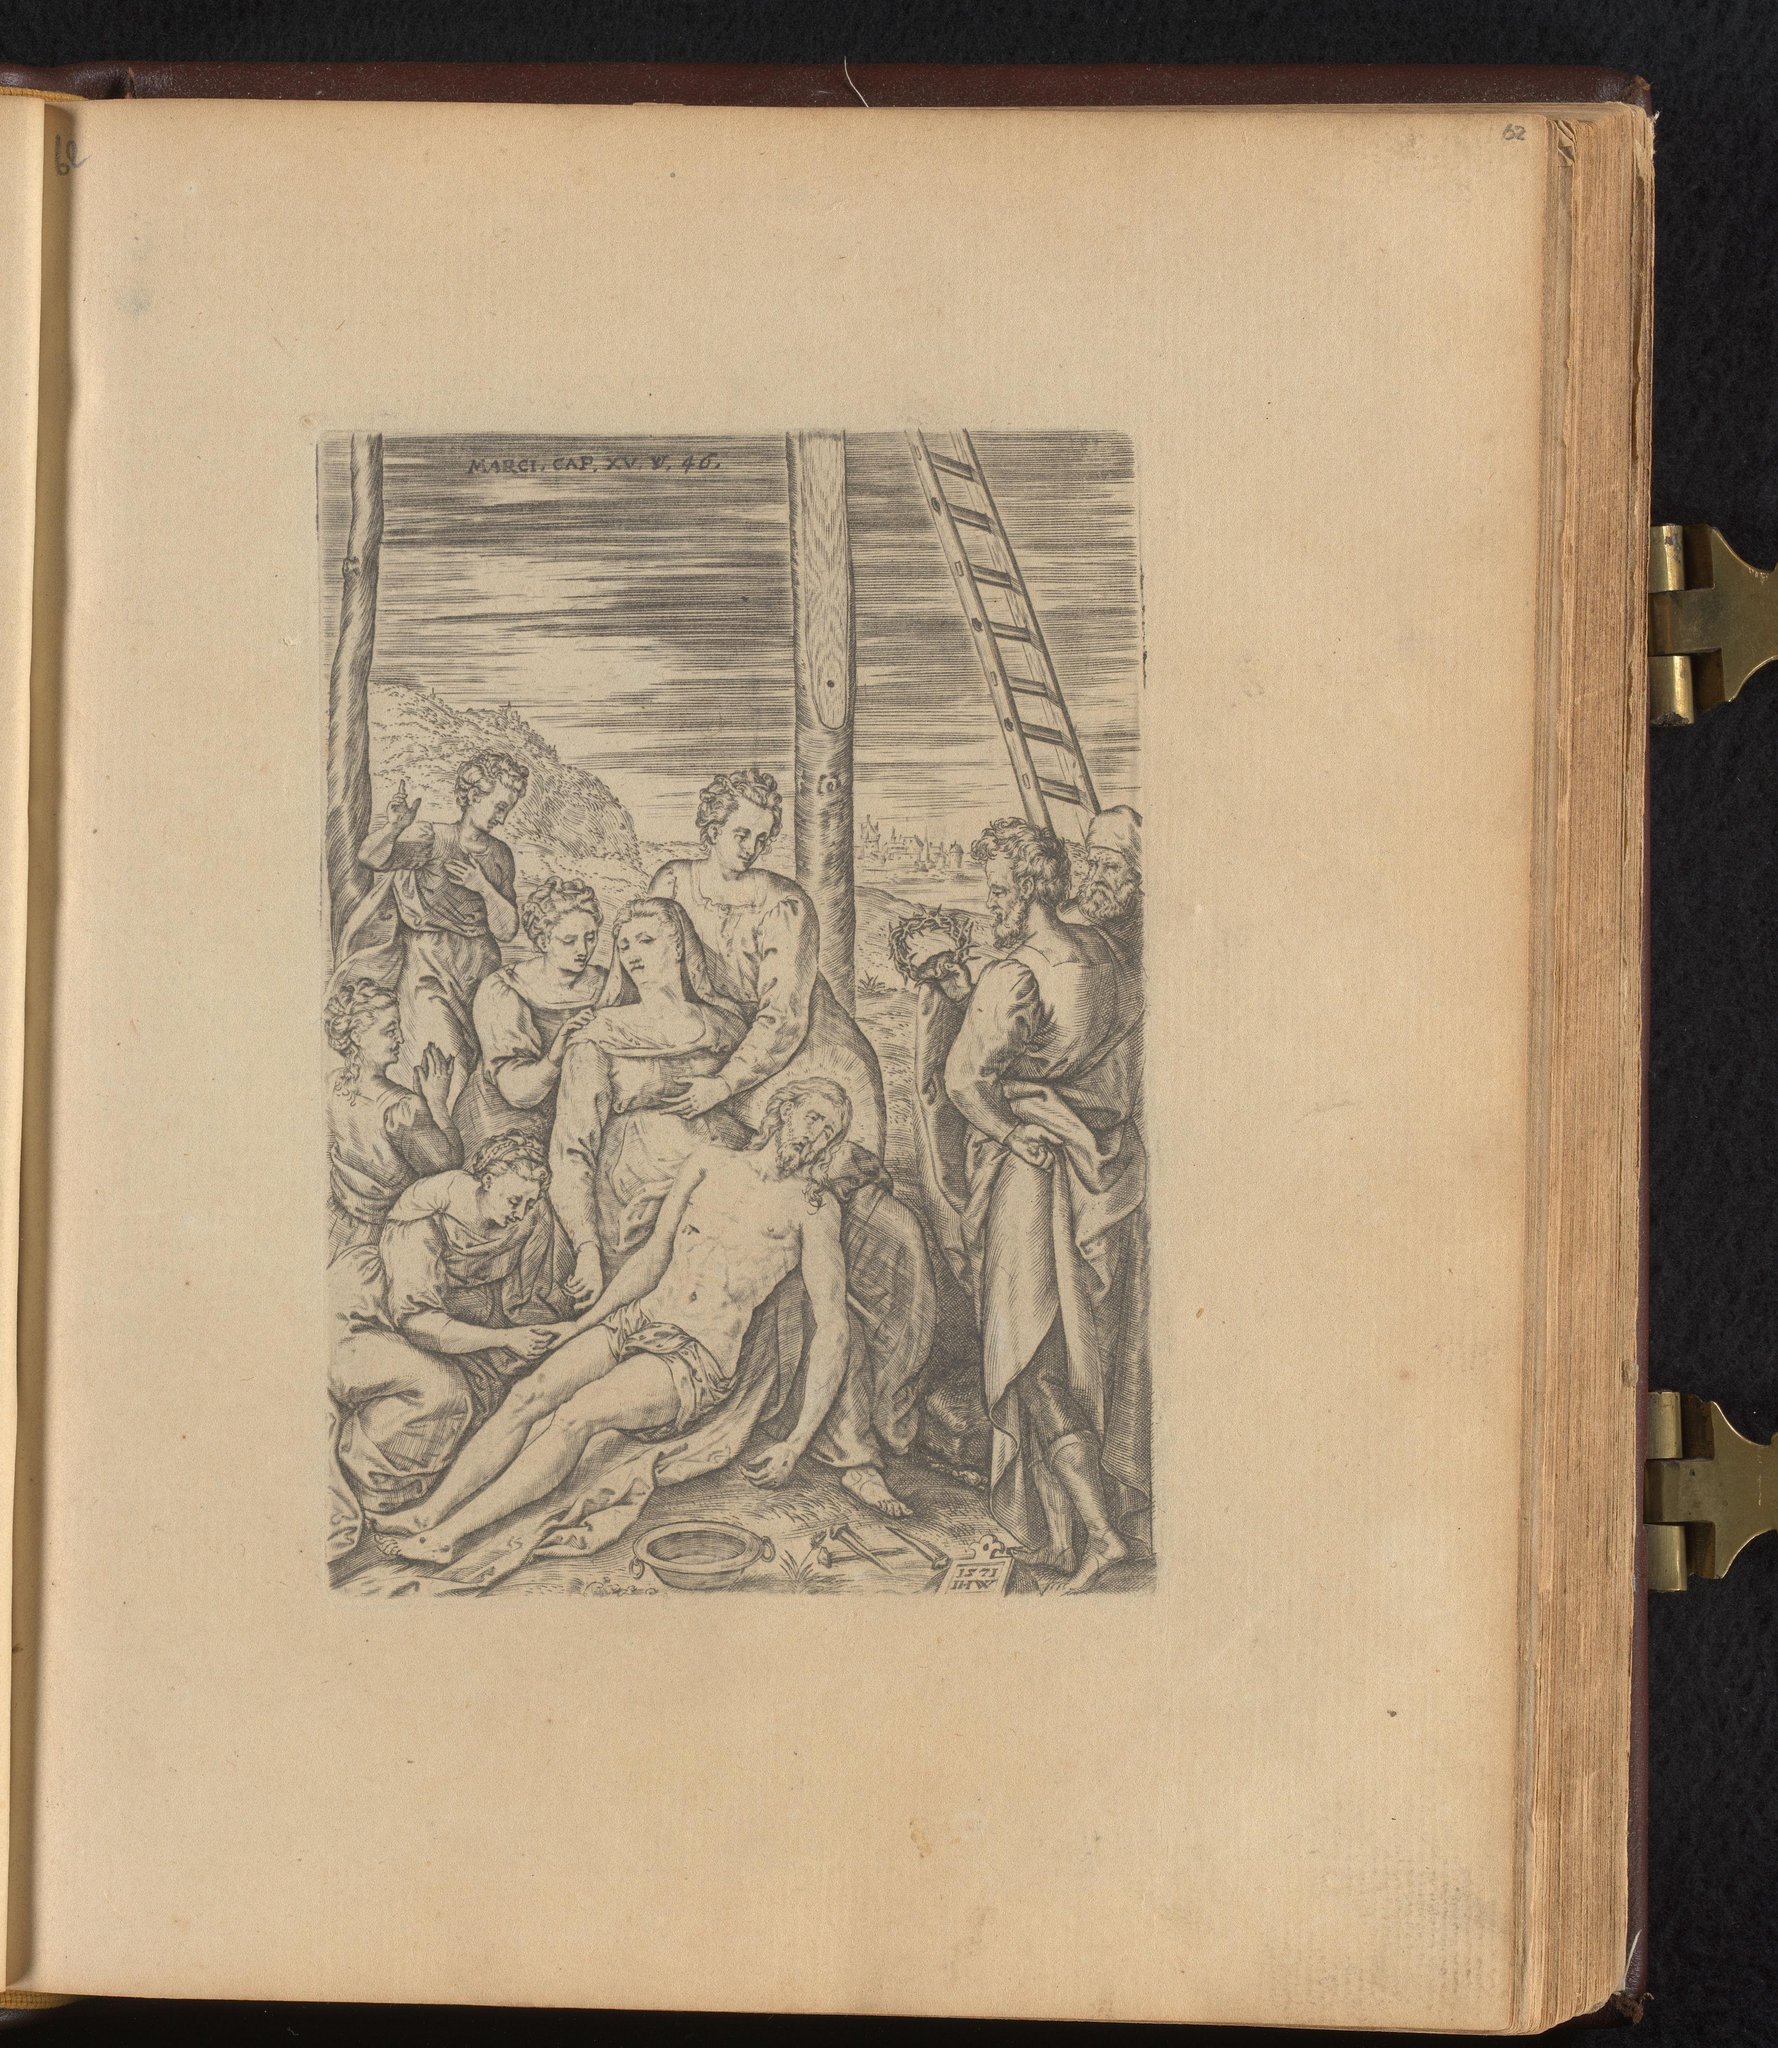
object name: album leaf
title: Bewening van Christus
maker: johannes wierix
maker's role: draughtsman, print maker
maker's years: 1549-1618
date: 1571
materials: paper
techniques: engraving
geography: antwerp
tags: the mourning over the dead christ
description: Eerdere staat van prent gebruikt als boekillustratie in: Theatrum Typographicum. Antwerpen: Jan Moretus, 1576.